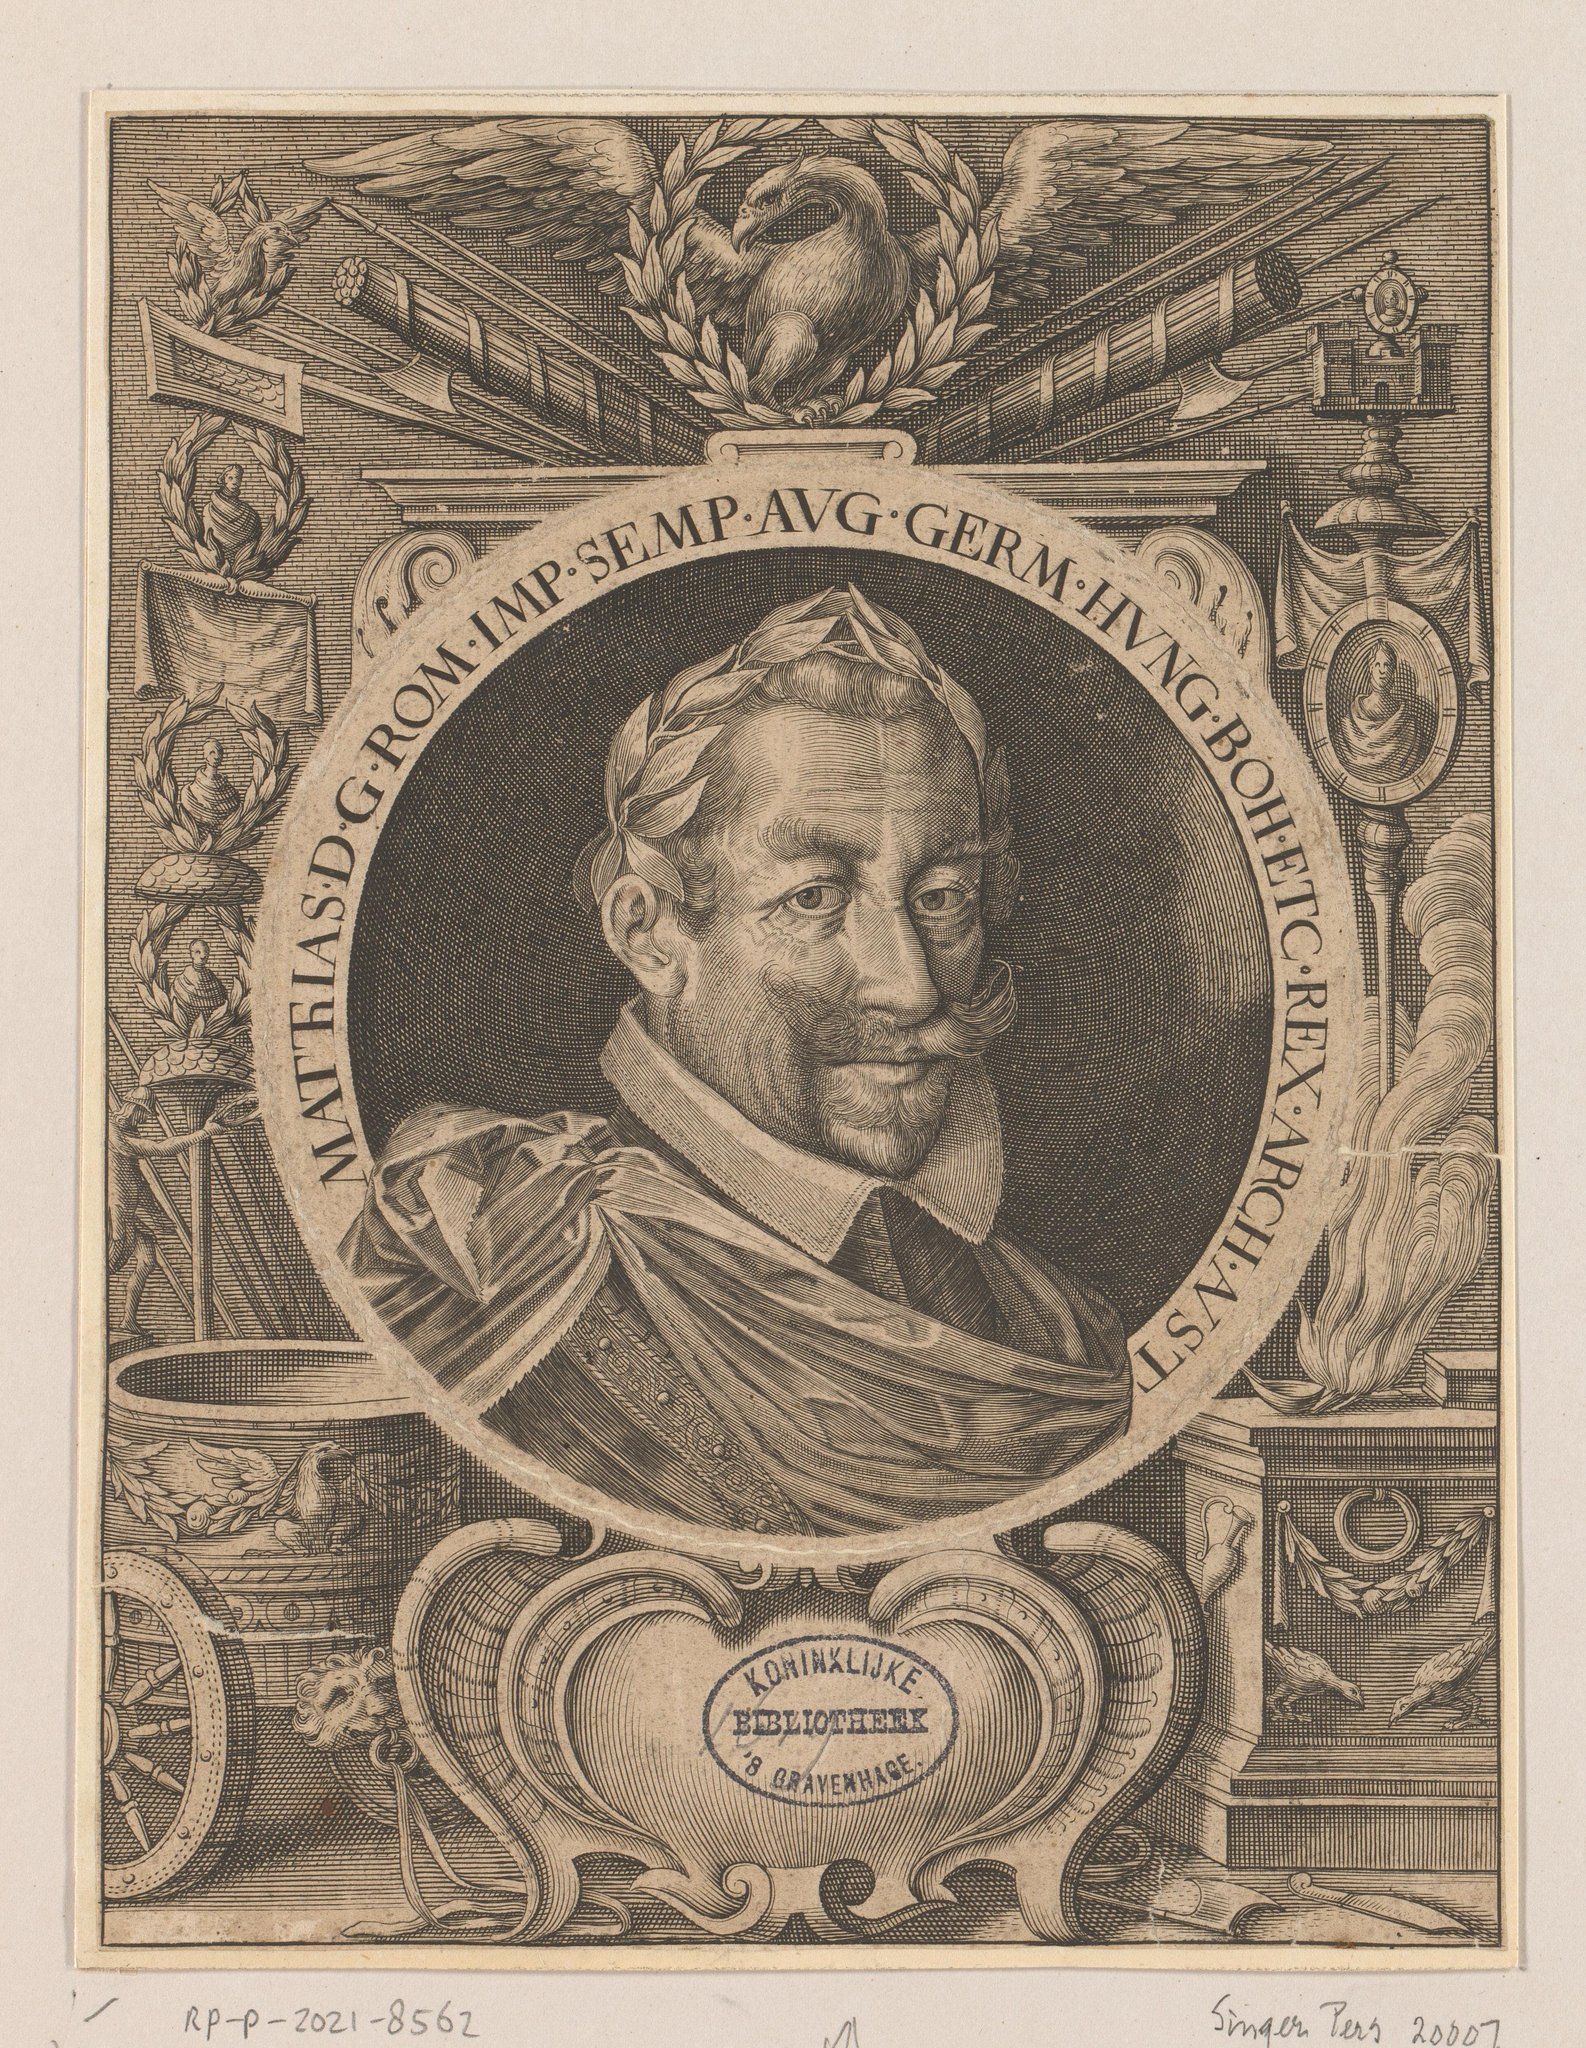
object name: print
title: Portret van keizer Matthias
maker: Anonymous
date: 1612-1699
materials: paper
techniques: engraving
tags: vienna, matthias van oostenrijk (rooms-duits keizer), historical persons, emperor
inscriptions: inscription: ‘KB’, collector's mark: Lugt 1097